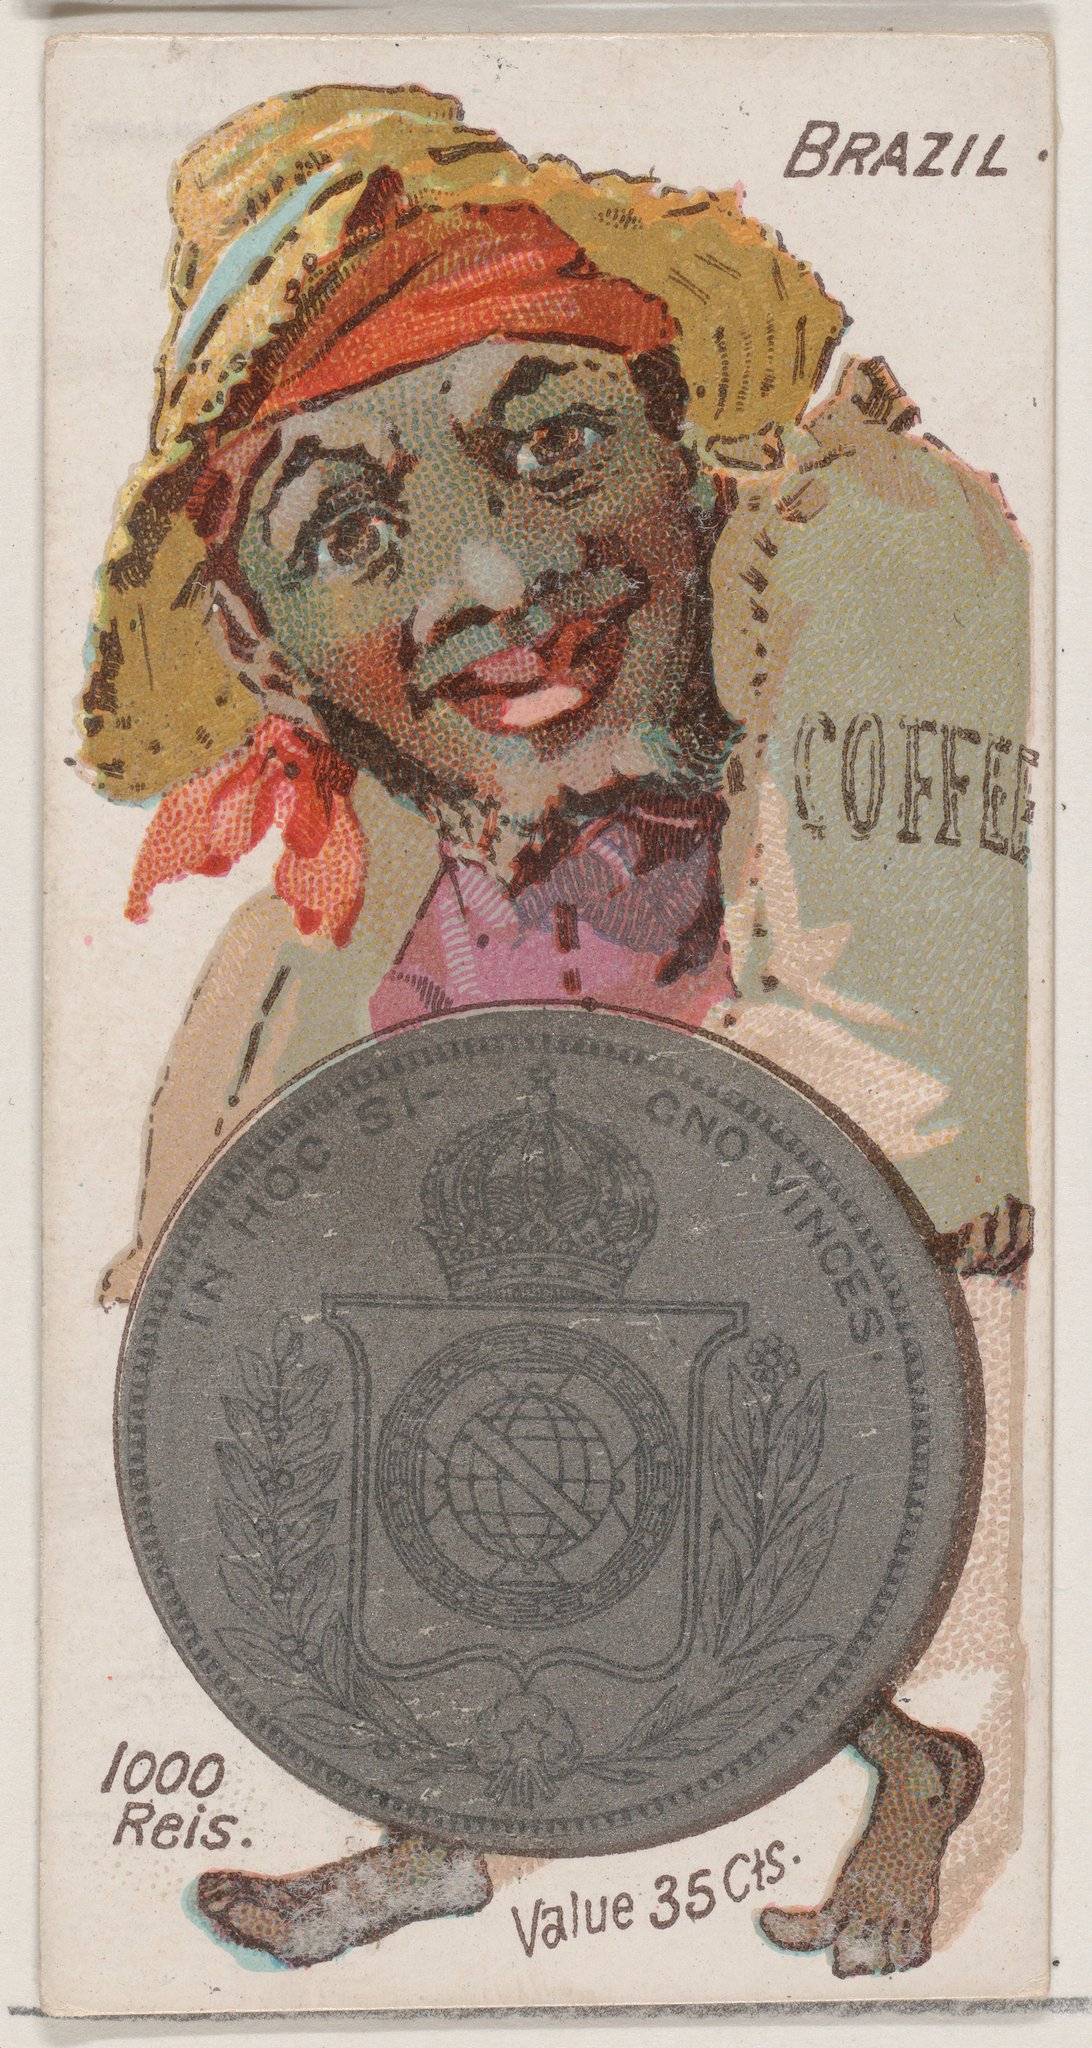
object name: print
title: Caricatured Brazilian, 1000 Reis, from the series Coins of All Nations (N72, variation 1) for Duke brand cigarettes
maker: w. duke, sons & co.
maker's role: publisher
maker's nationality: american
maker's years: 1870-1920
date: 1889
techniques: color lithograph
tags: coins